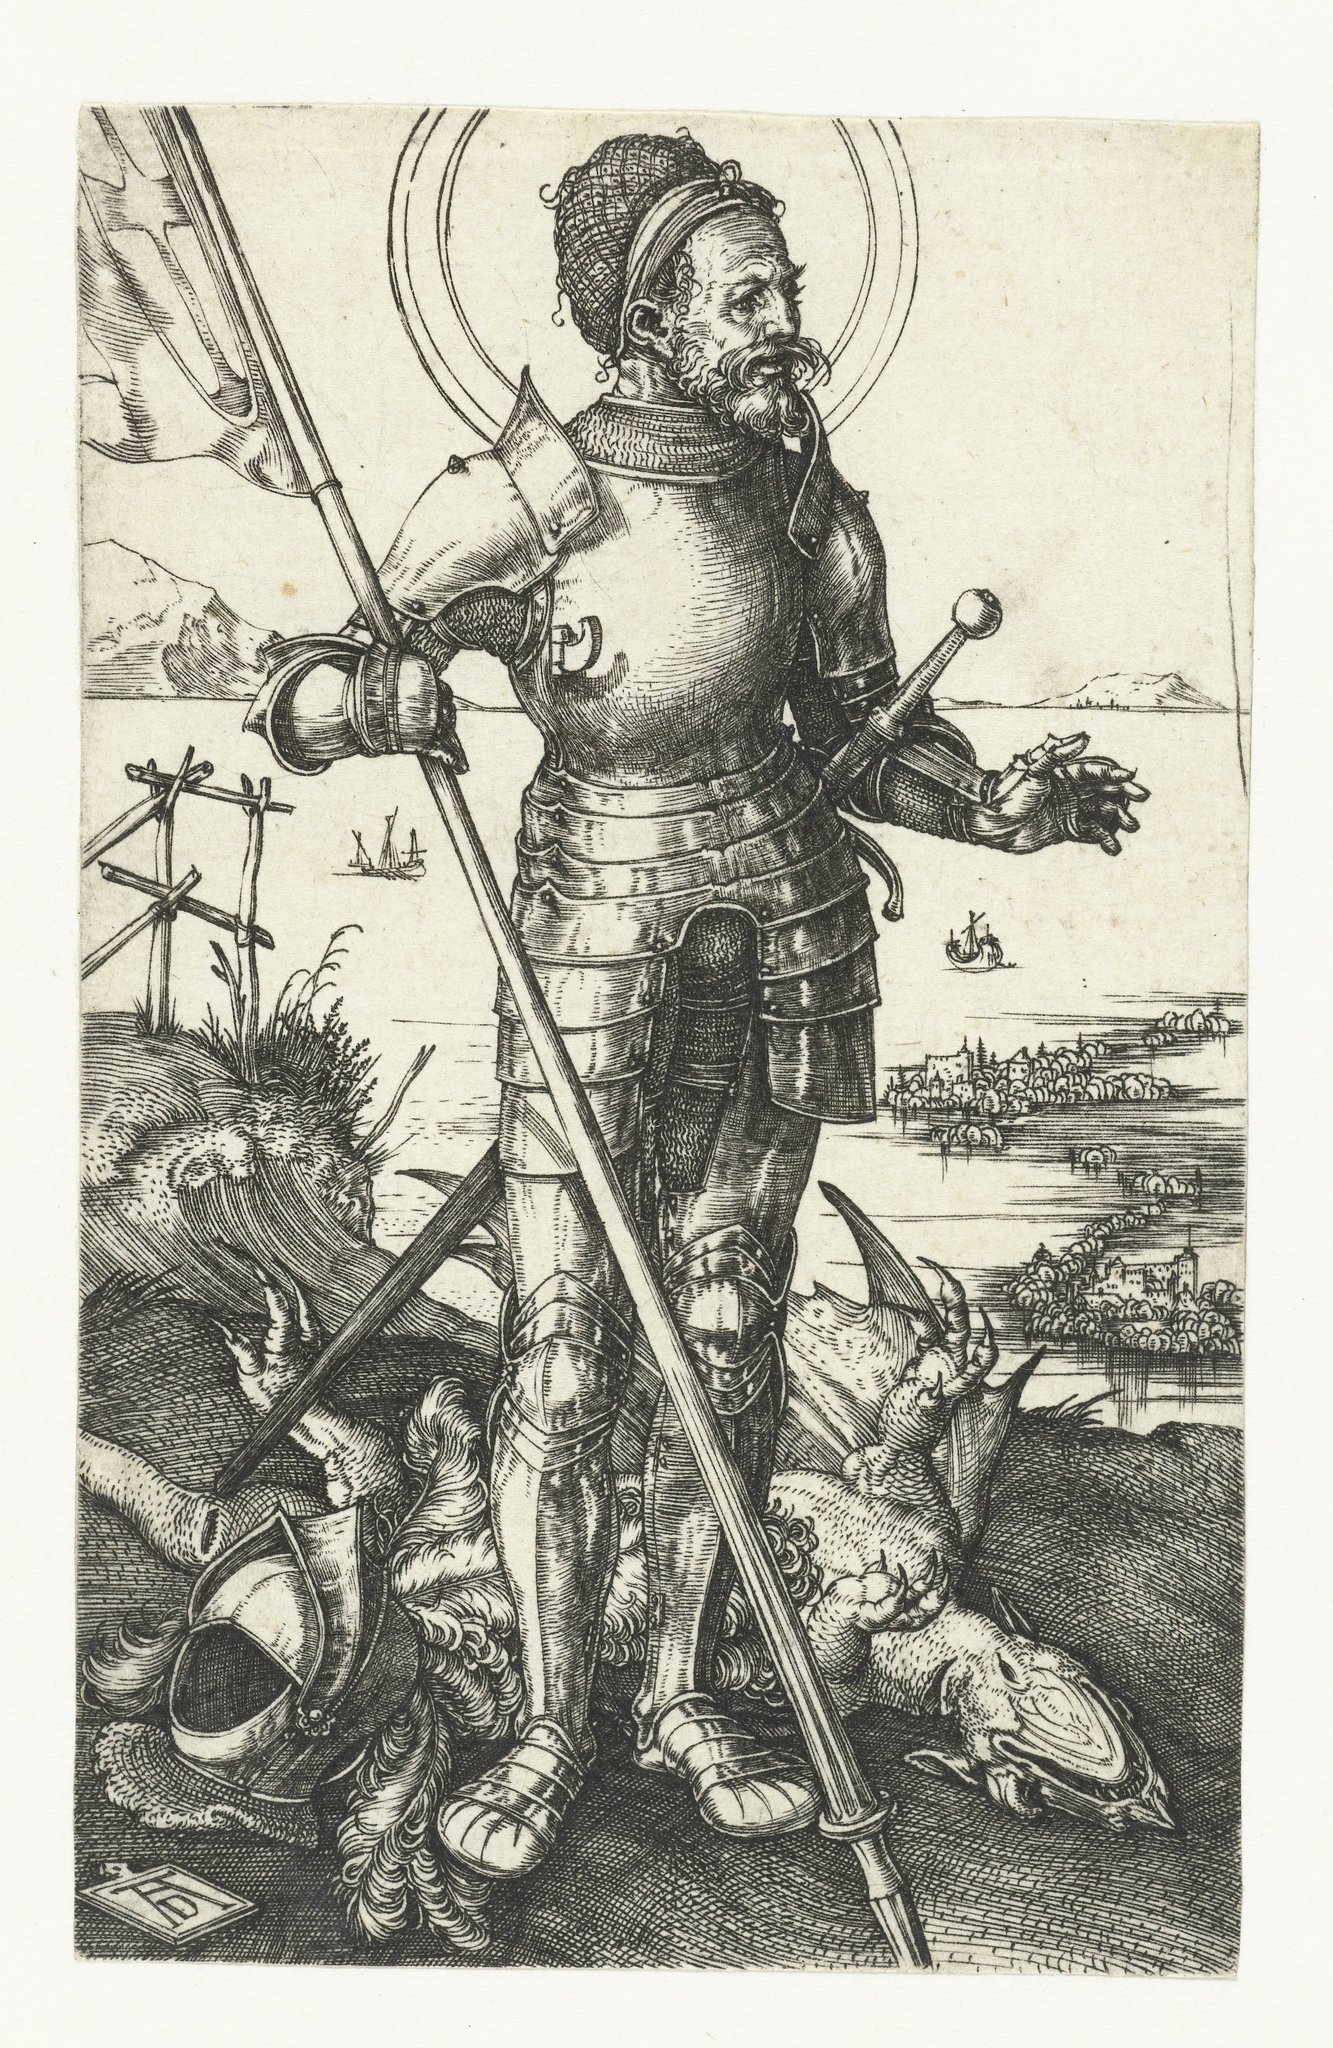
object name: print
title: De Heilige Joris staand naast de gedode draak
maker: albrecht dürer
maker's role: draughtsman, painter, print maker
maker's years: 1471-1528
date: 1500-1505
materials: paper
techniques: engraving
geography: nuremberg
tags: the warrior martyr george (georgius); possible attributes: banner (red cross on white field), (red) cross, dragon, (white) horse, broken lance, shield (with cross), sword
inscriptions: collector's mark: Lugt 2228a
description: De Heilige Joris, in harnas, staand naast de draak die hij gedood heeft. Op de achtergrond een baai.